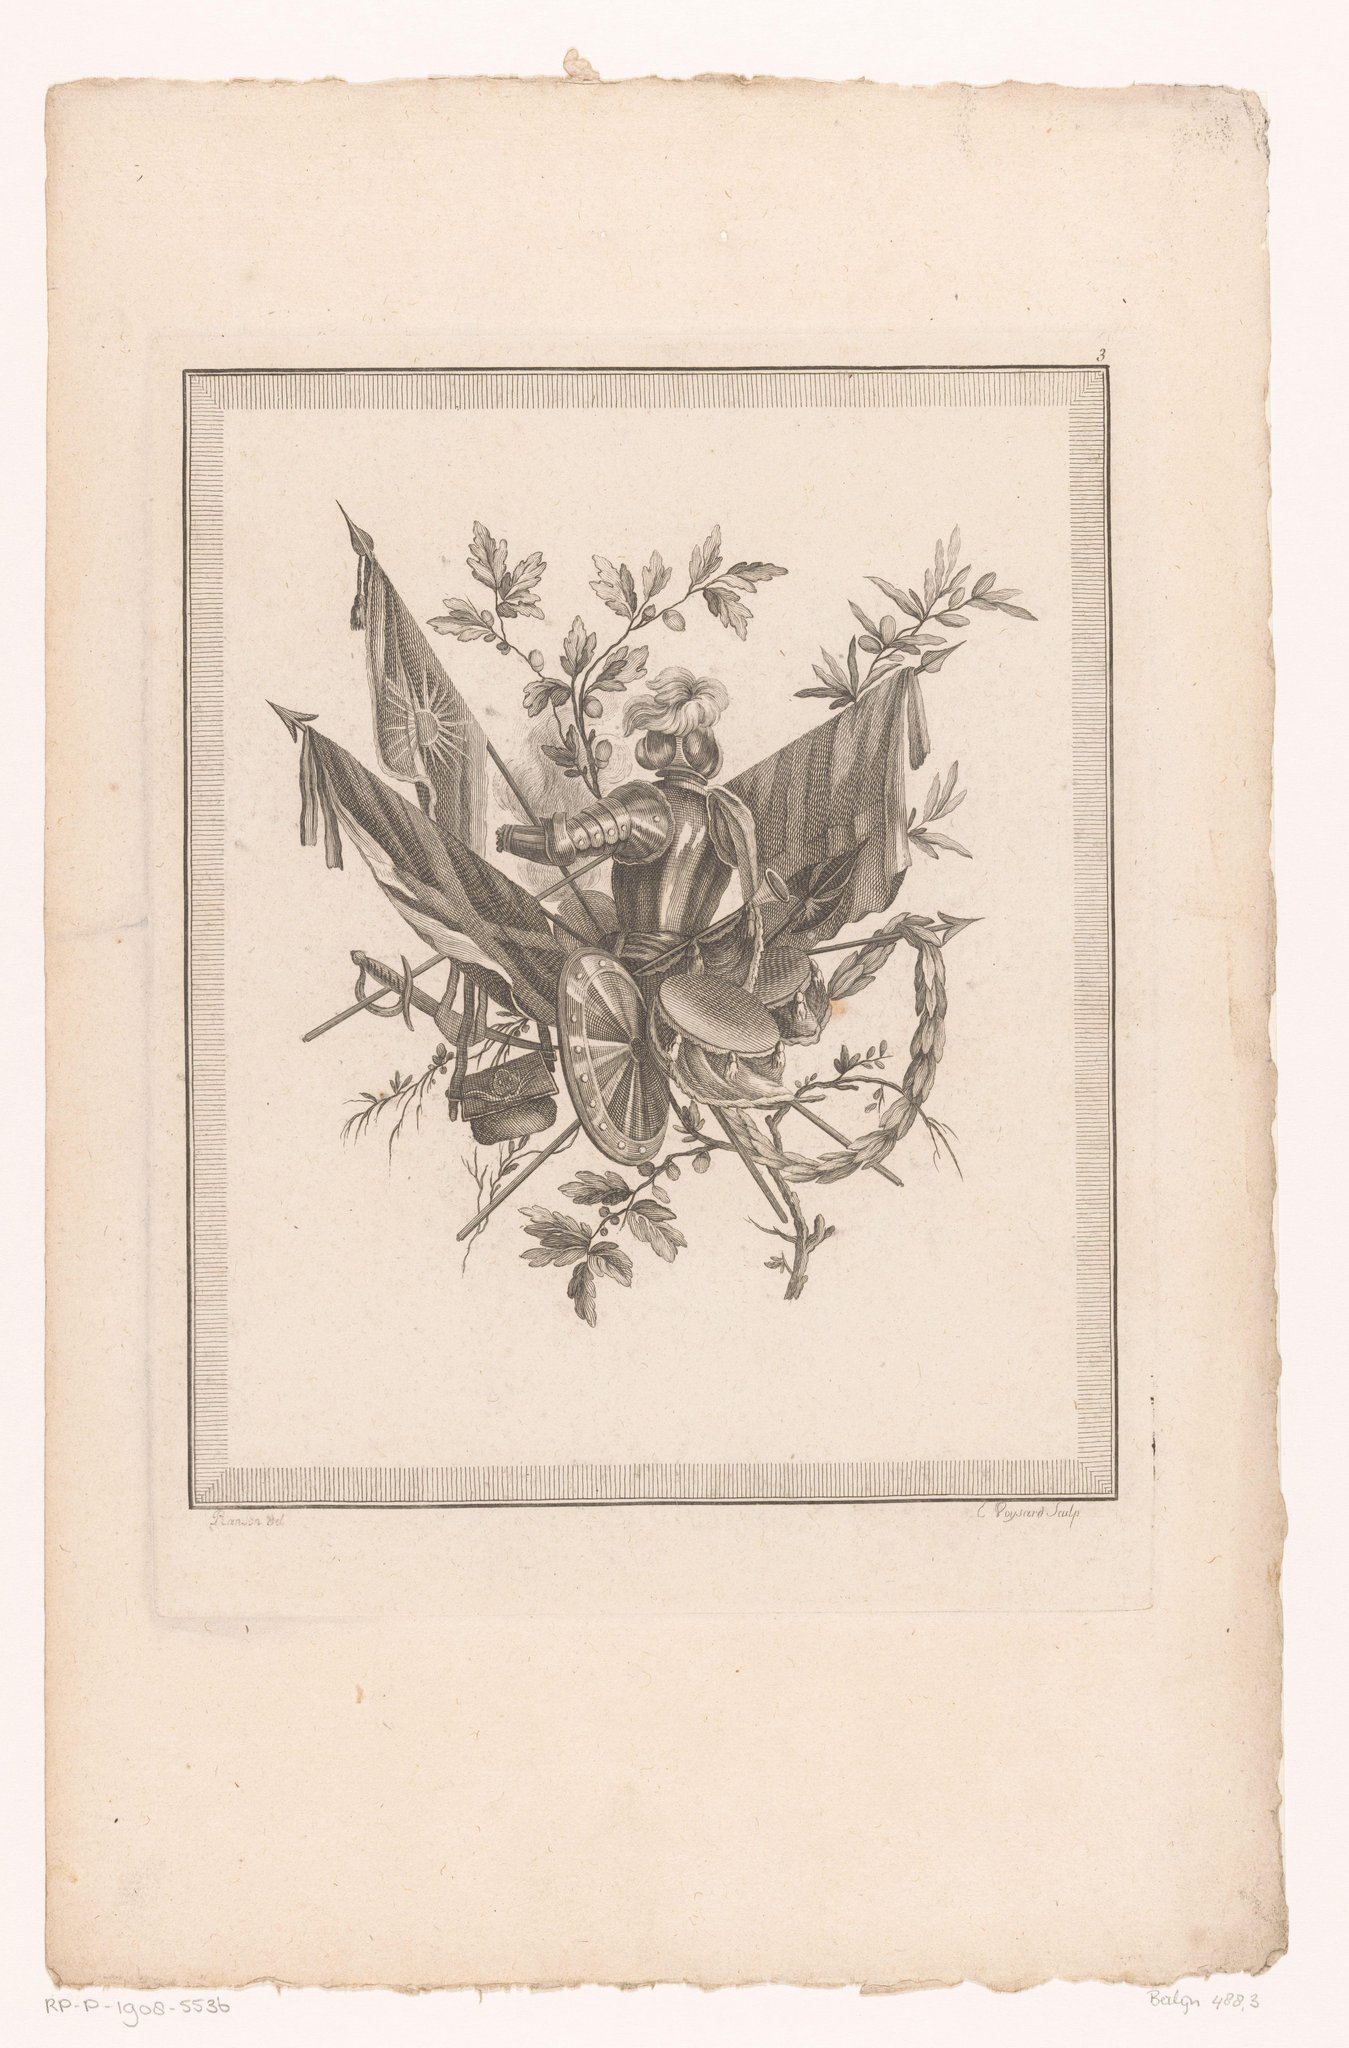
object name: ornament print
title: Wapentrofee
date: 1778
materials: paper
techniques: etching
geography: paris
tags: 'tropaion', i.e. decorative ornament ~ weapons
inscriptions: collector's mark: Lugt 2228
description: Een wapentrofee met vlaggen, een harnas, een bazuin en trommels, een schild en een tas.